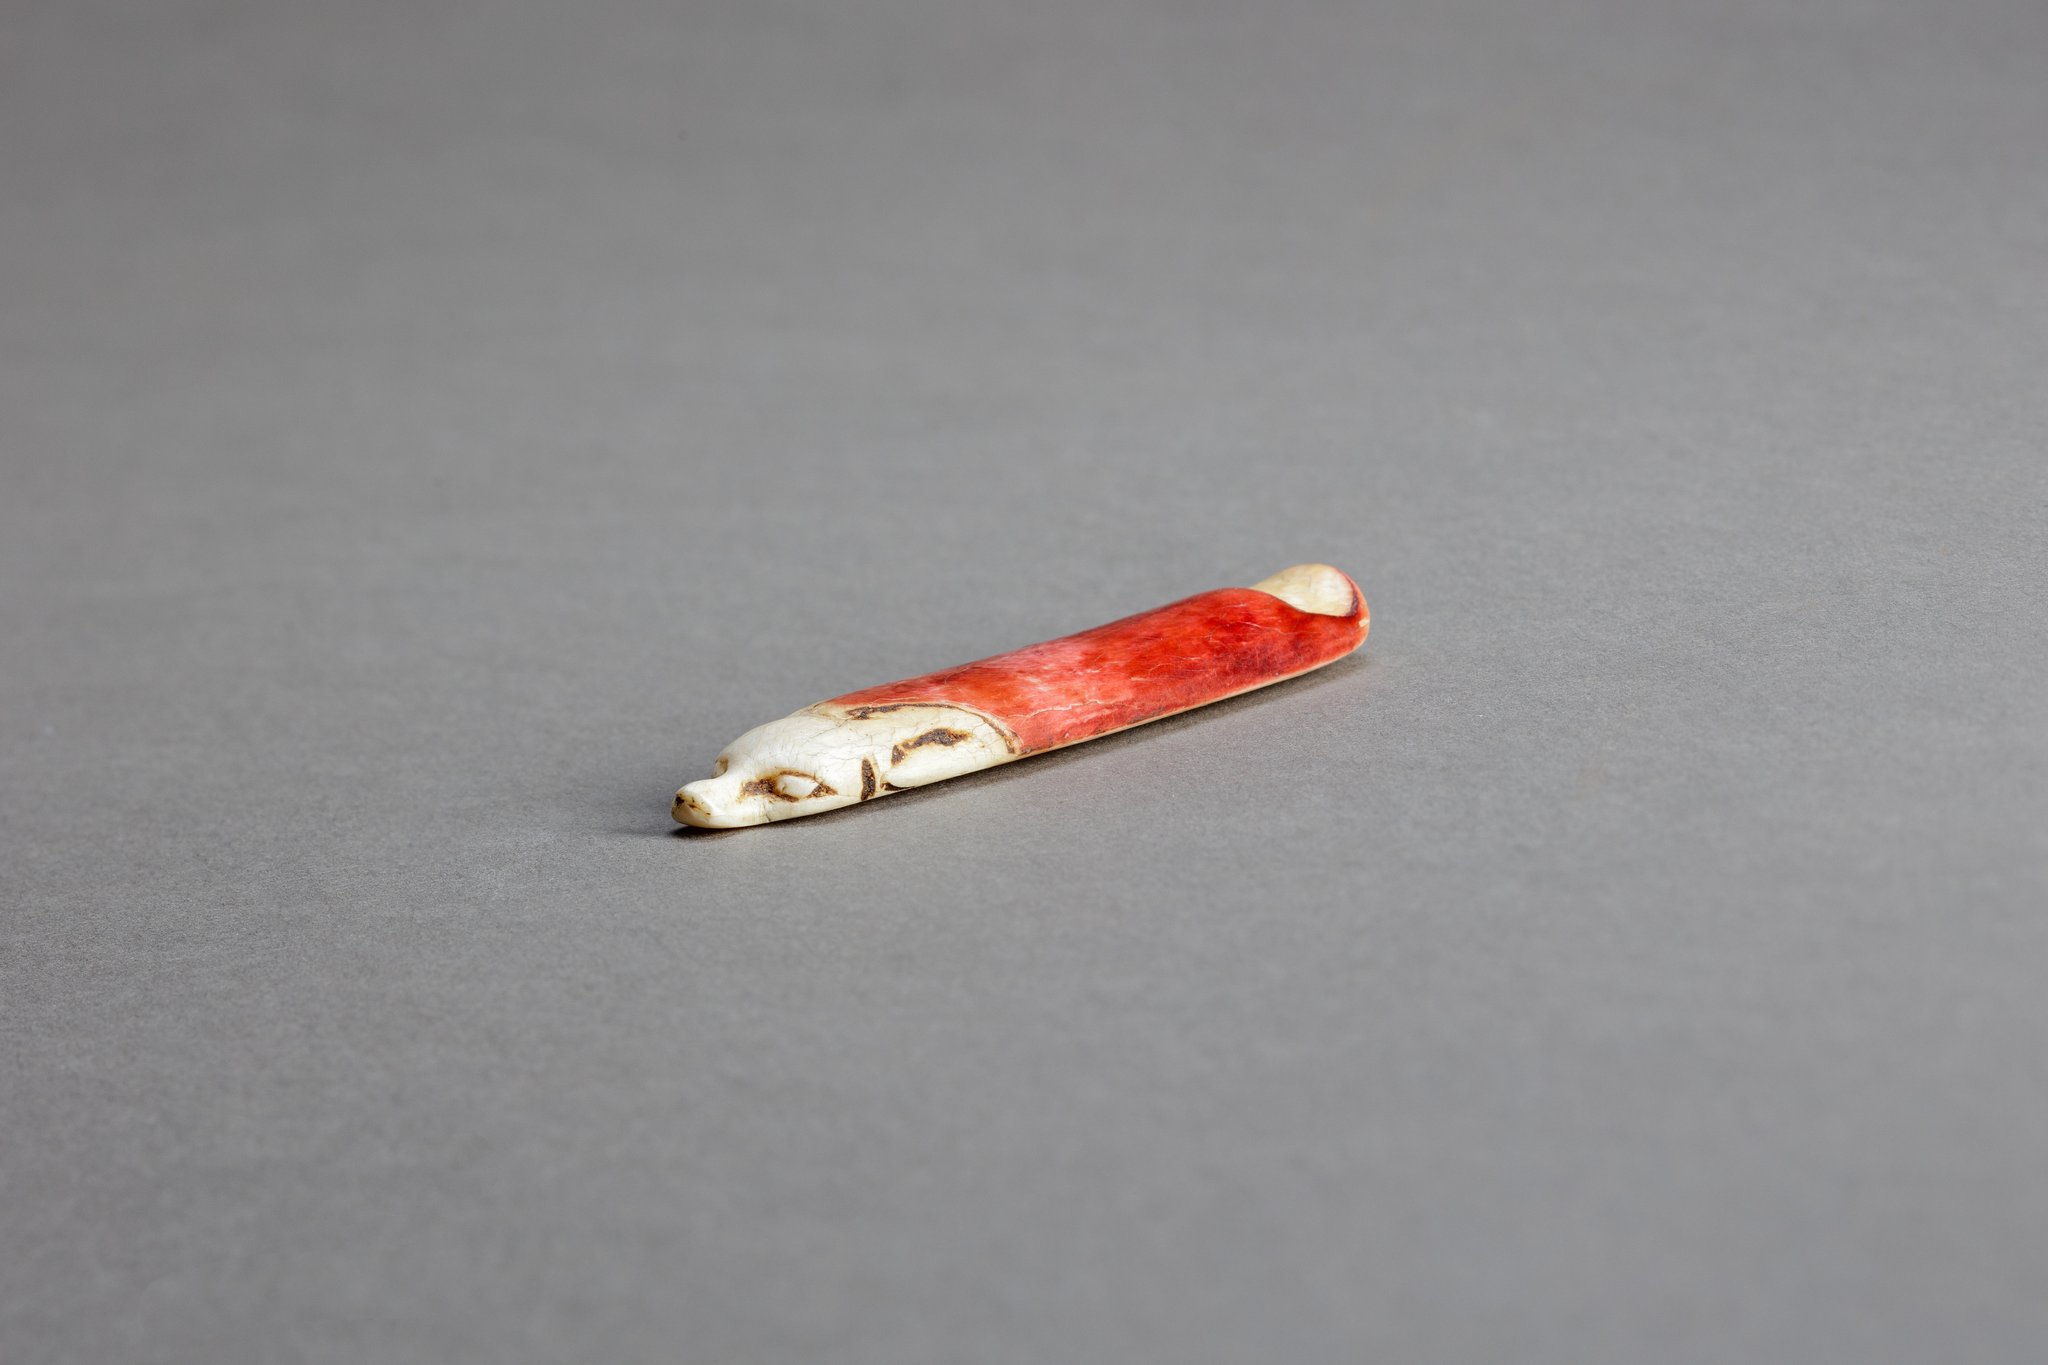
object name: throw stick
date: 1400-1295 BCE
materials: ivory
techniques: tinting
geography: upper egypt, thebes